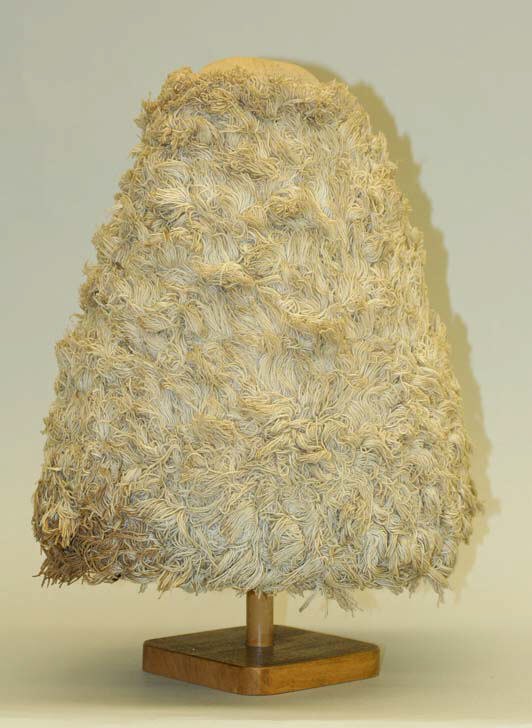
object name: cap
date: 1701-1900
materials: cotton